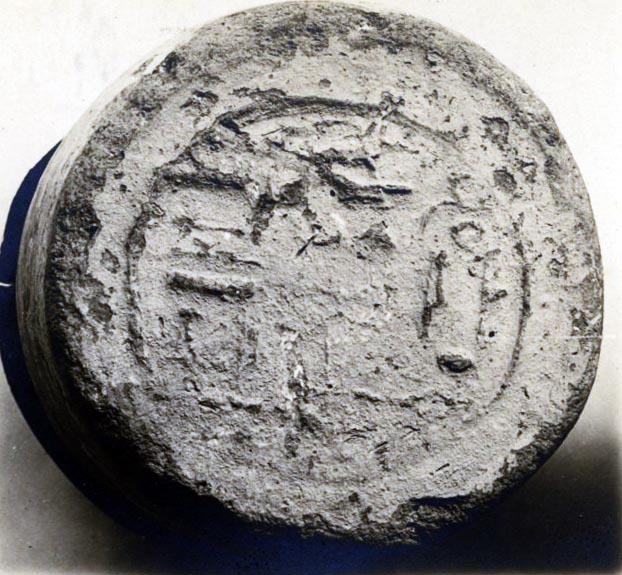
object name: cone, seshi, circular impression, overseer, ship, amun, anubis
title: Funerary Cone of the Overseer of the Ships of Amun Seshi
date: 1550-1295 BCE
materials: pottery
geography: egypt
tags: hieroglyphs